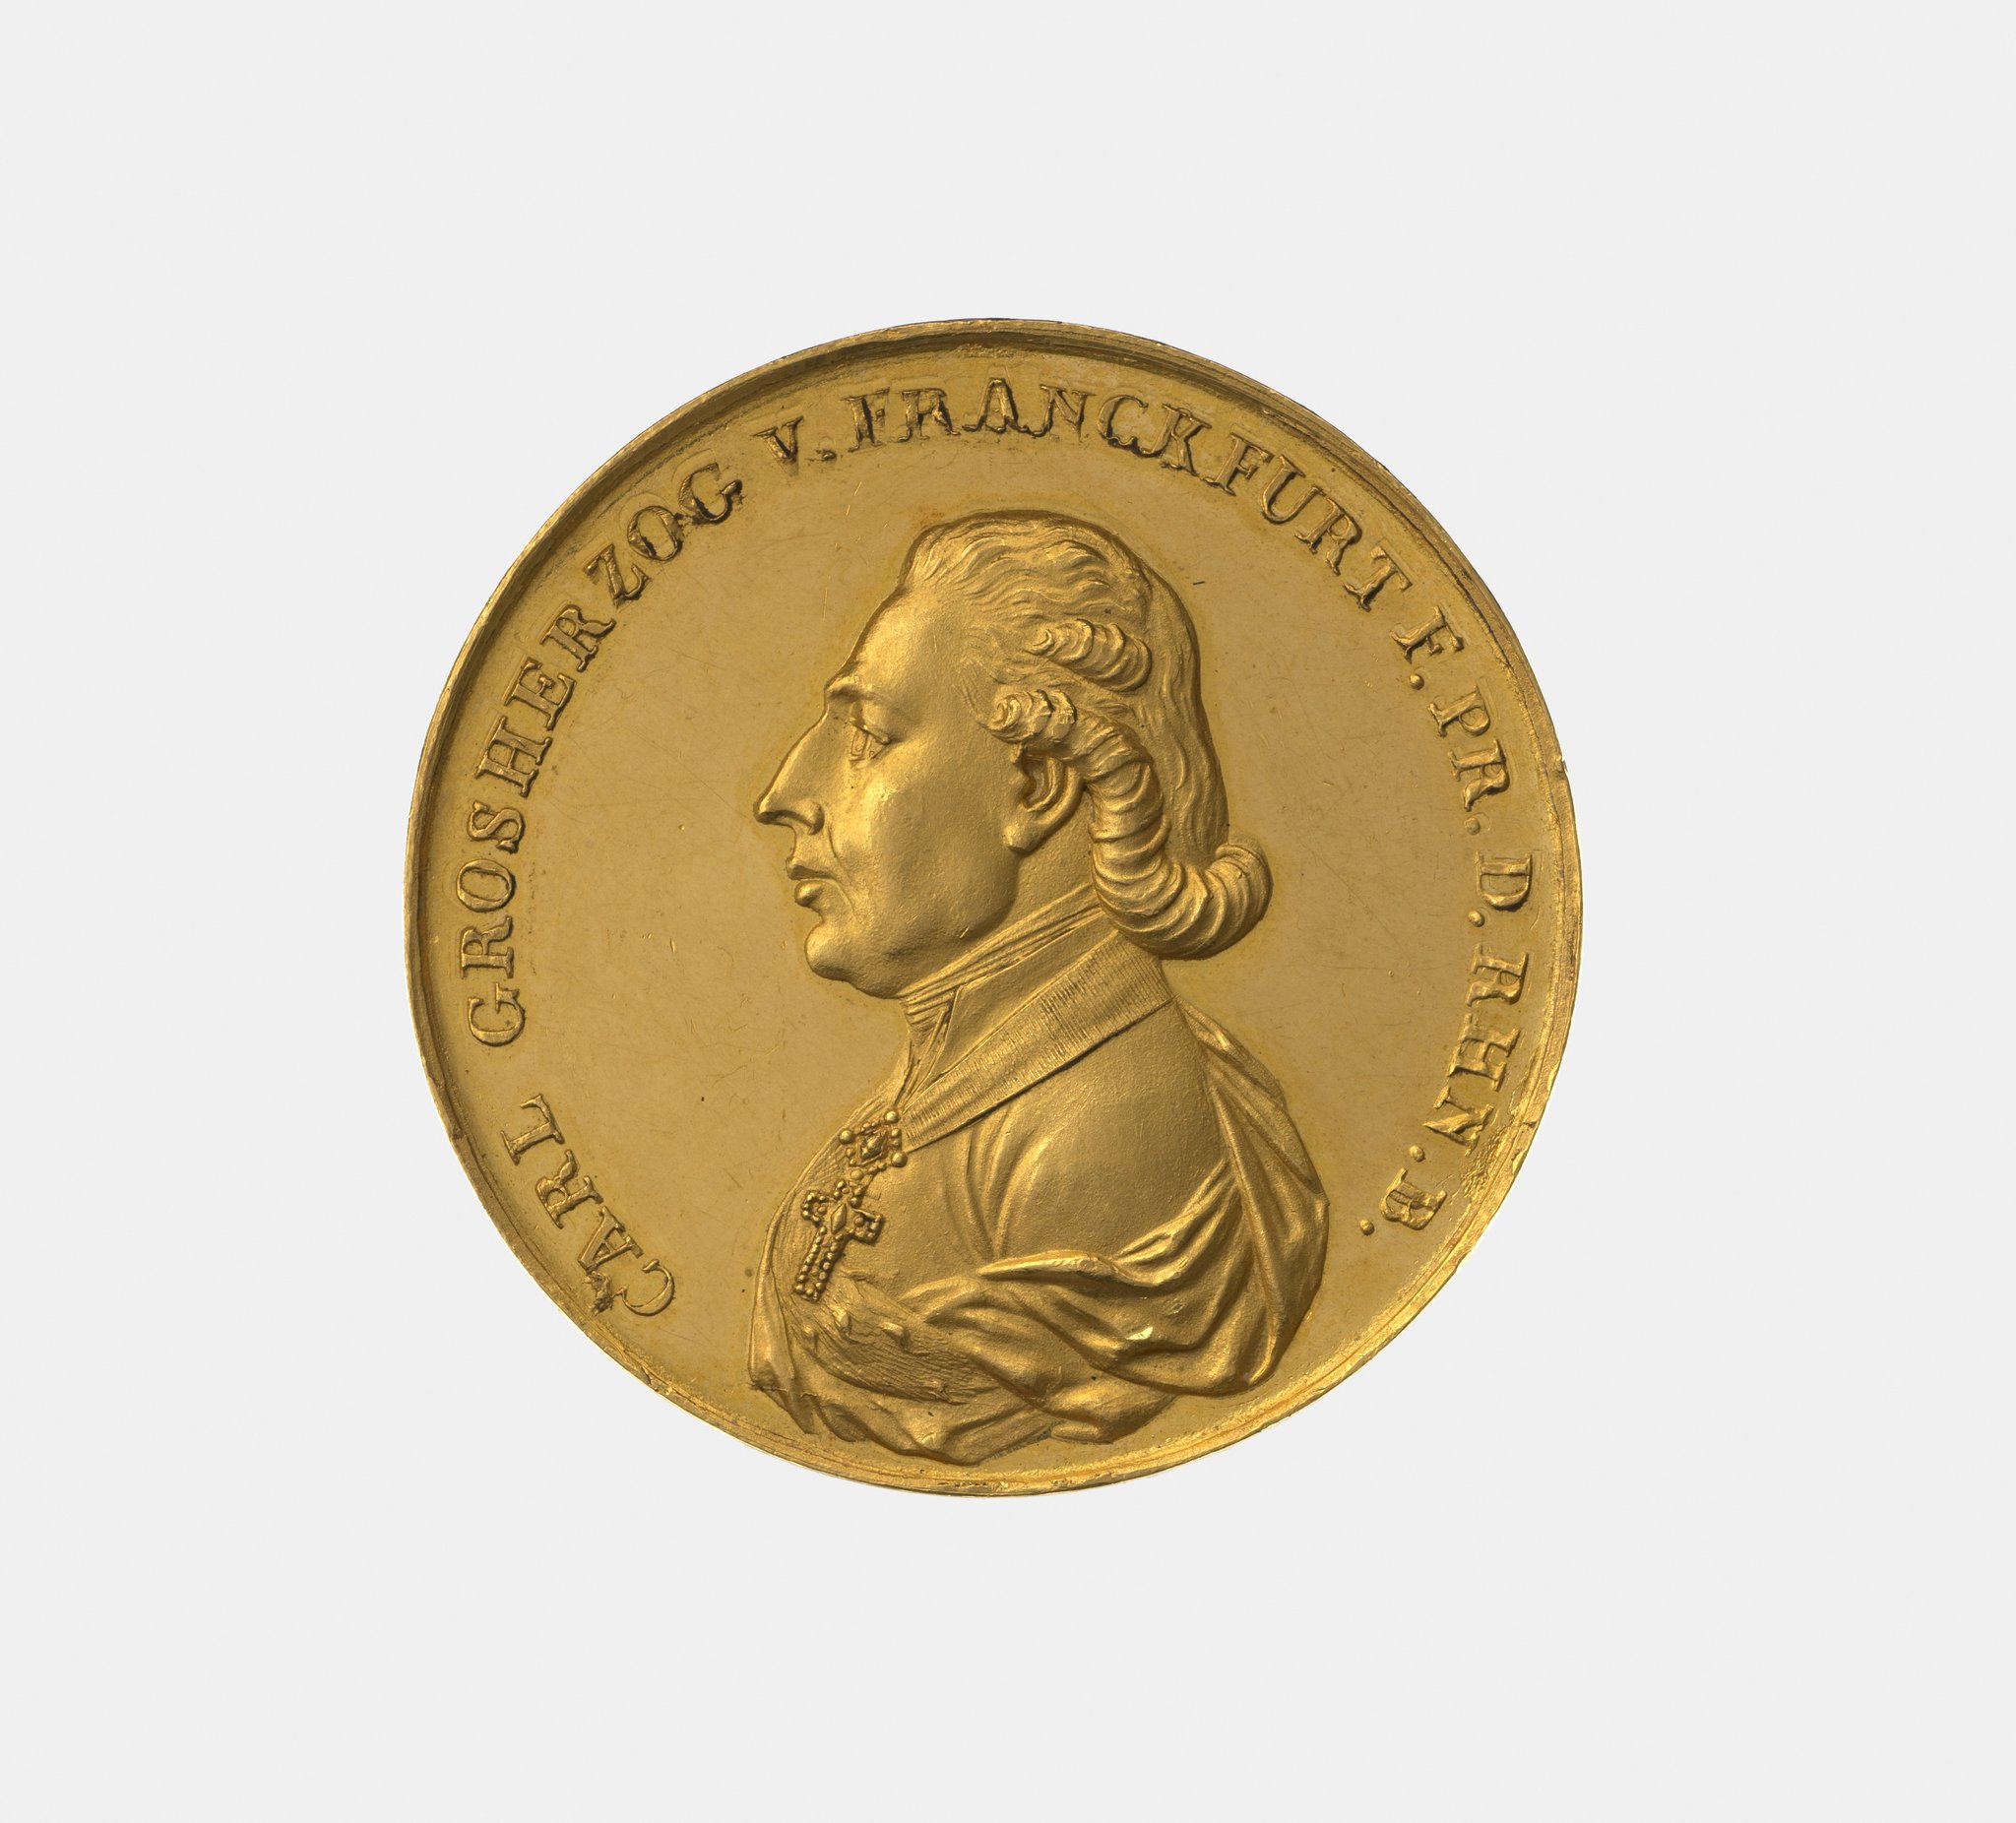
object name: medal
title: Karl Theodor Anton Maria von Dalberg / 10-ducat medal on establishment of Grand-Duchy of Frankfurt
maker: johann christian reich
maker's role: medailleur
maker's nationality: german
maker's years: 1740-1814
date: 1810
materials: gold